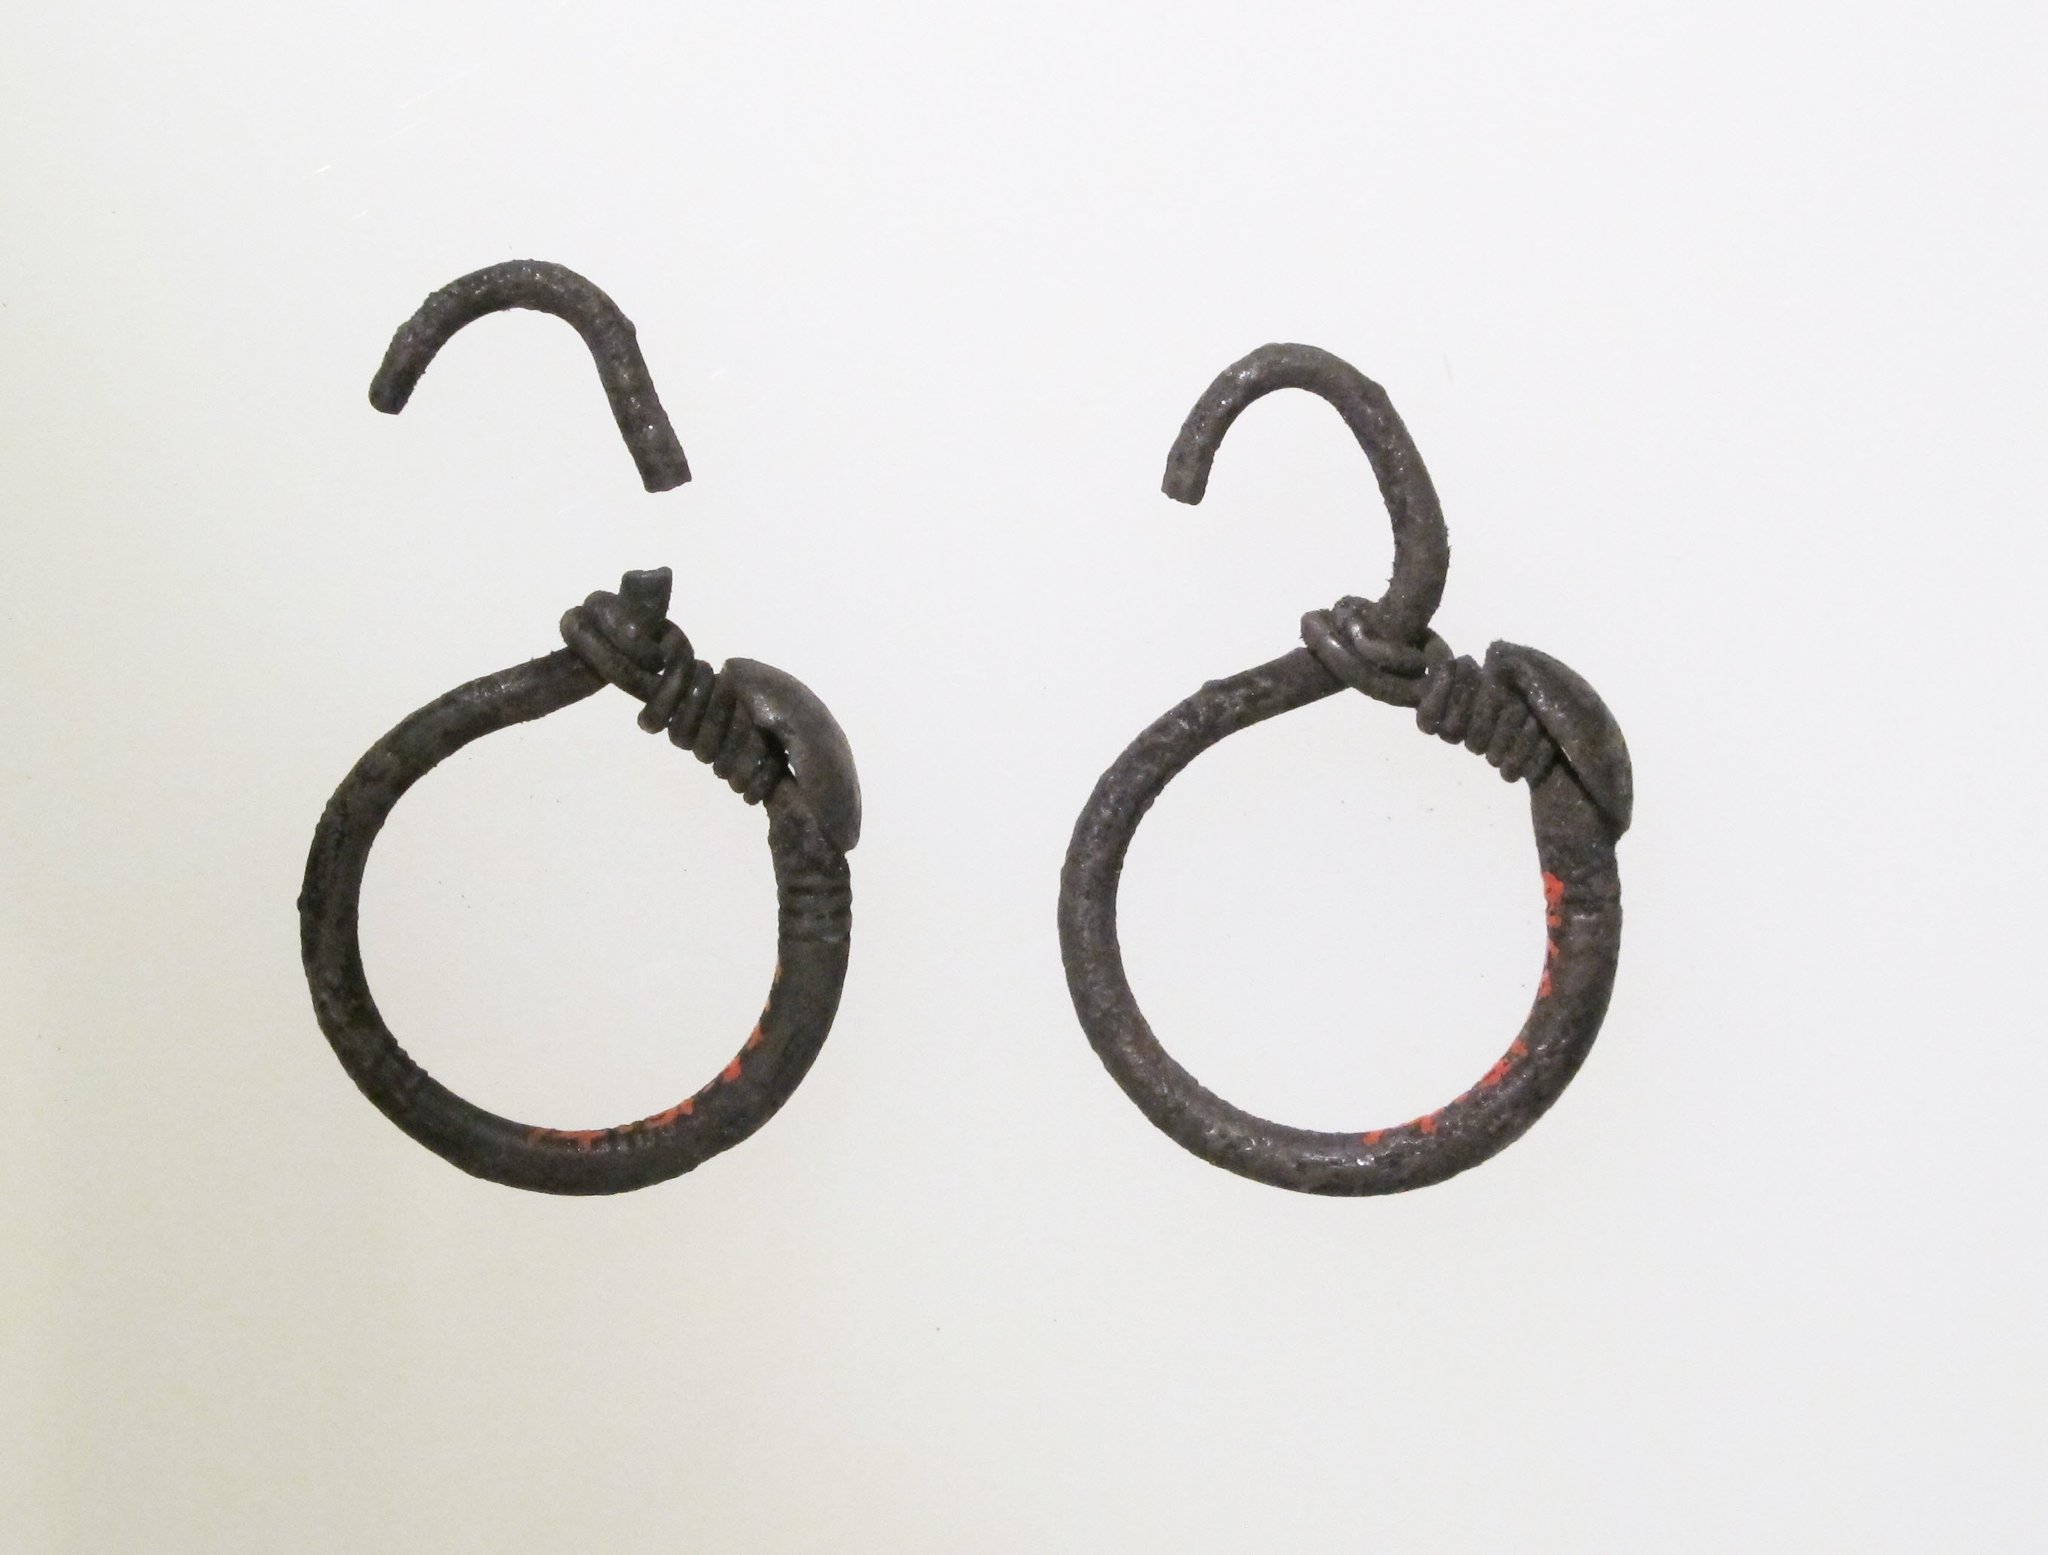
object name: earring, delta shaped with disc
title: Earring, delta-shaped with disc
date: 7000 BCE-330 CE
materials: silver